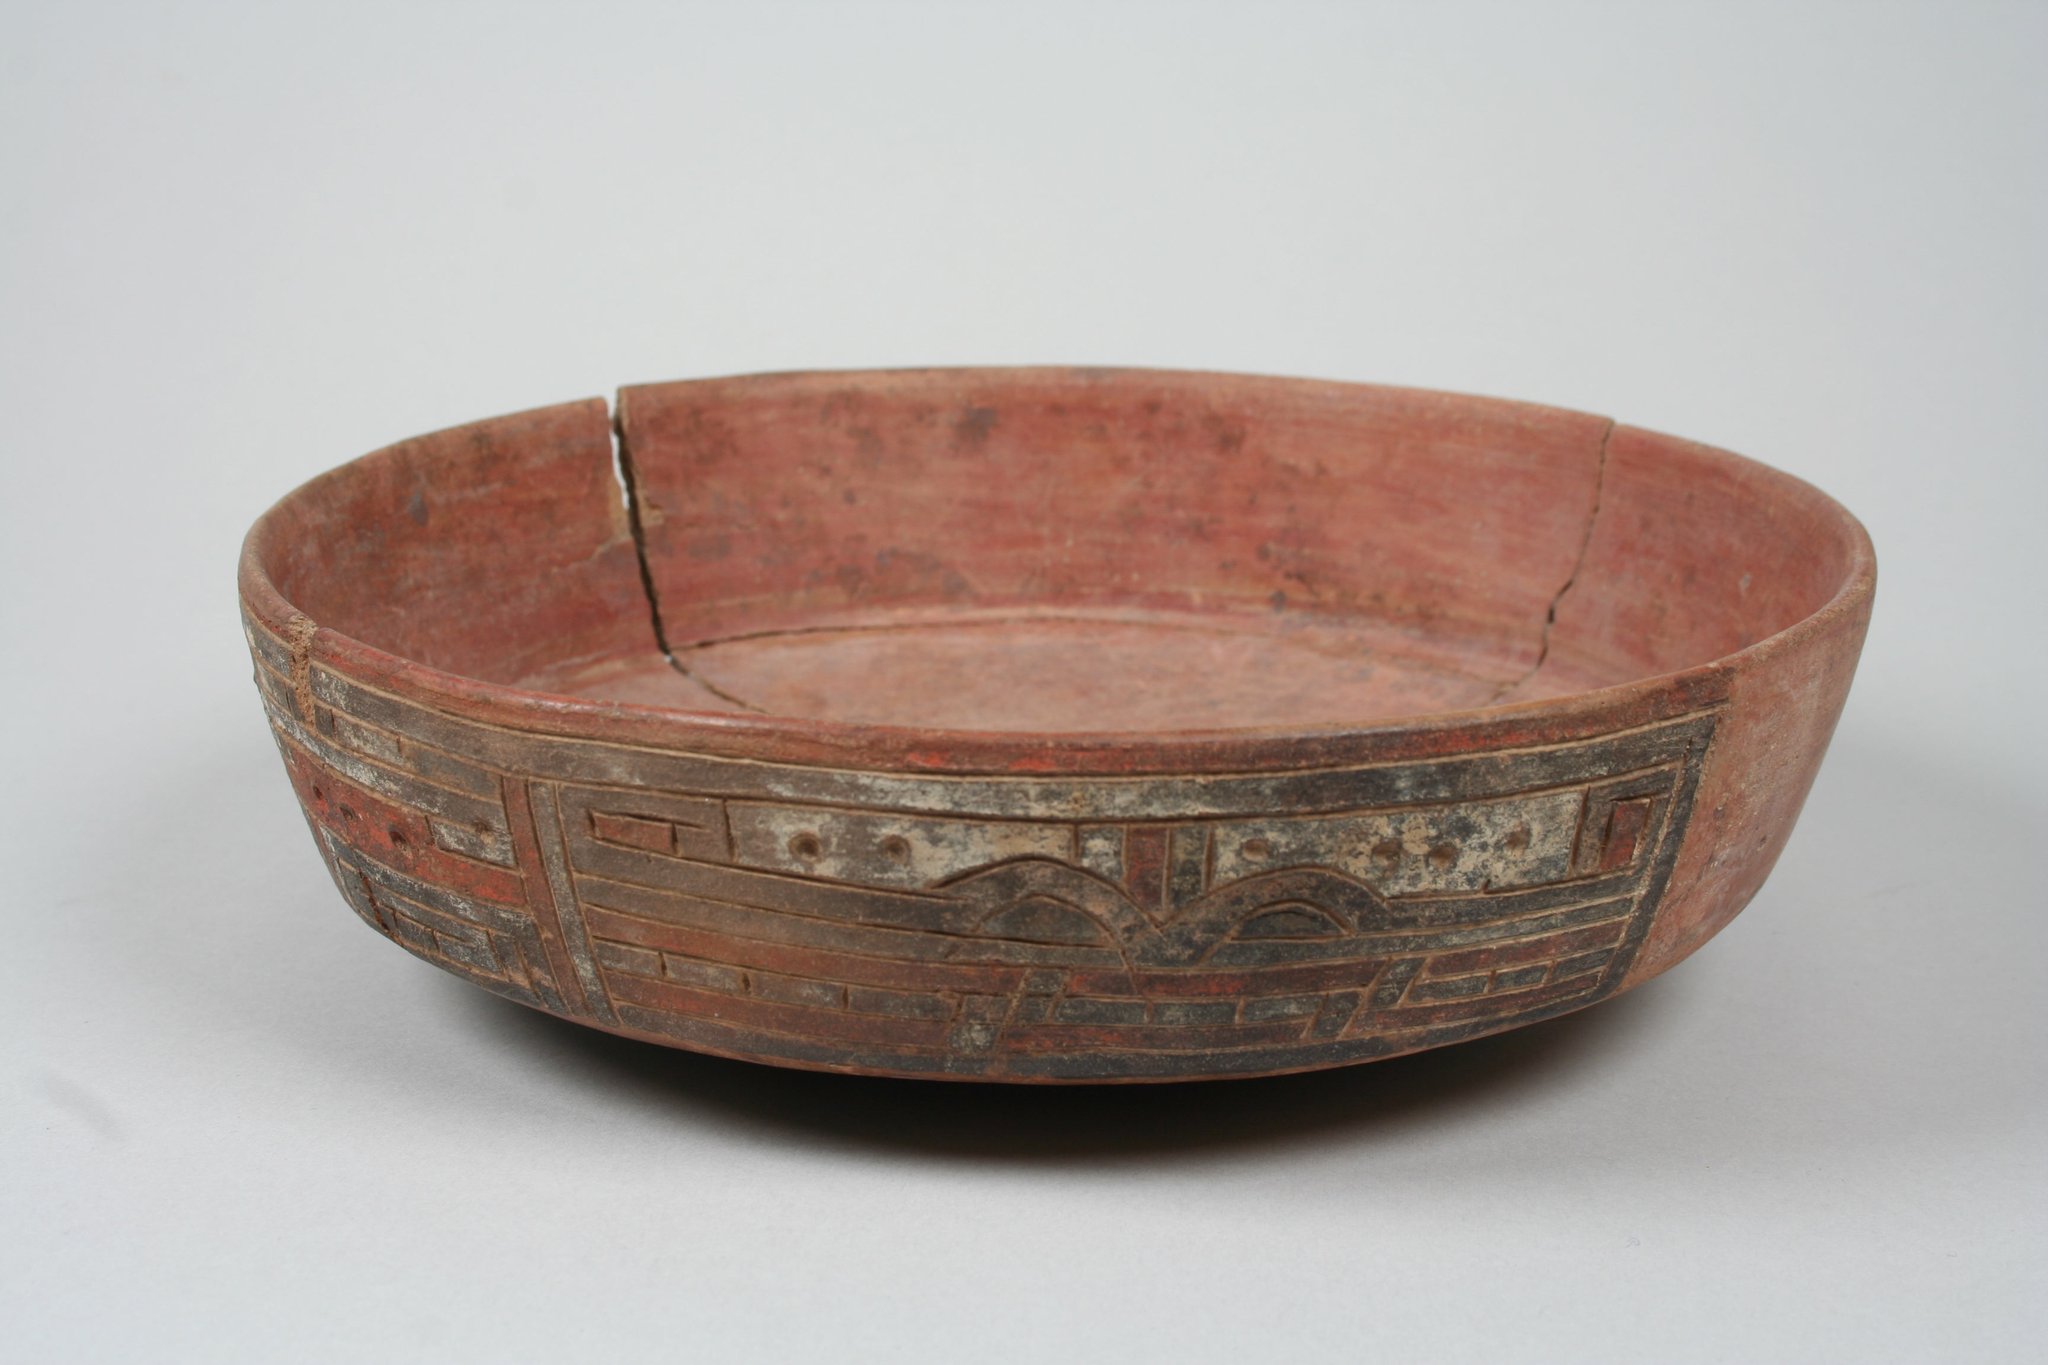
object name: bowl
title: Incised bowl with felines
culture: paracas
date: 700-401 BCE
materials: ceramic, pigment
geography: peru